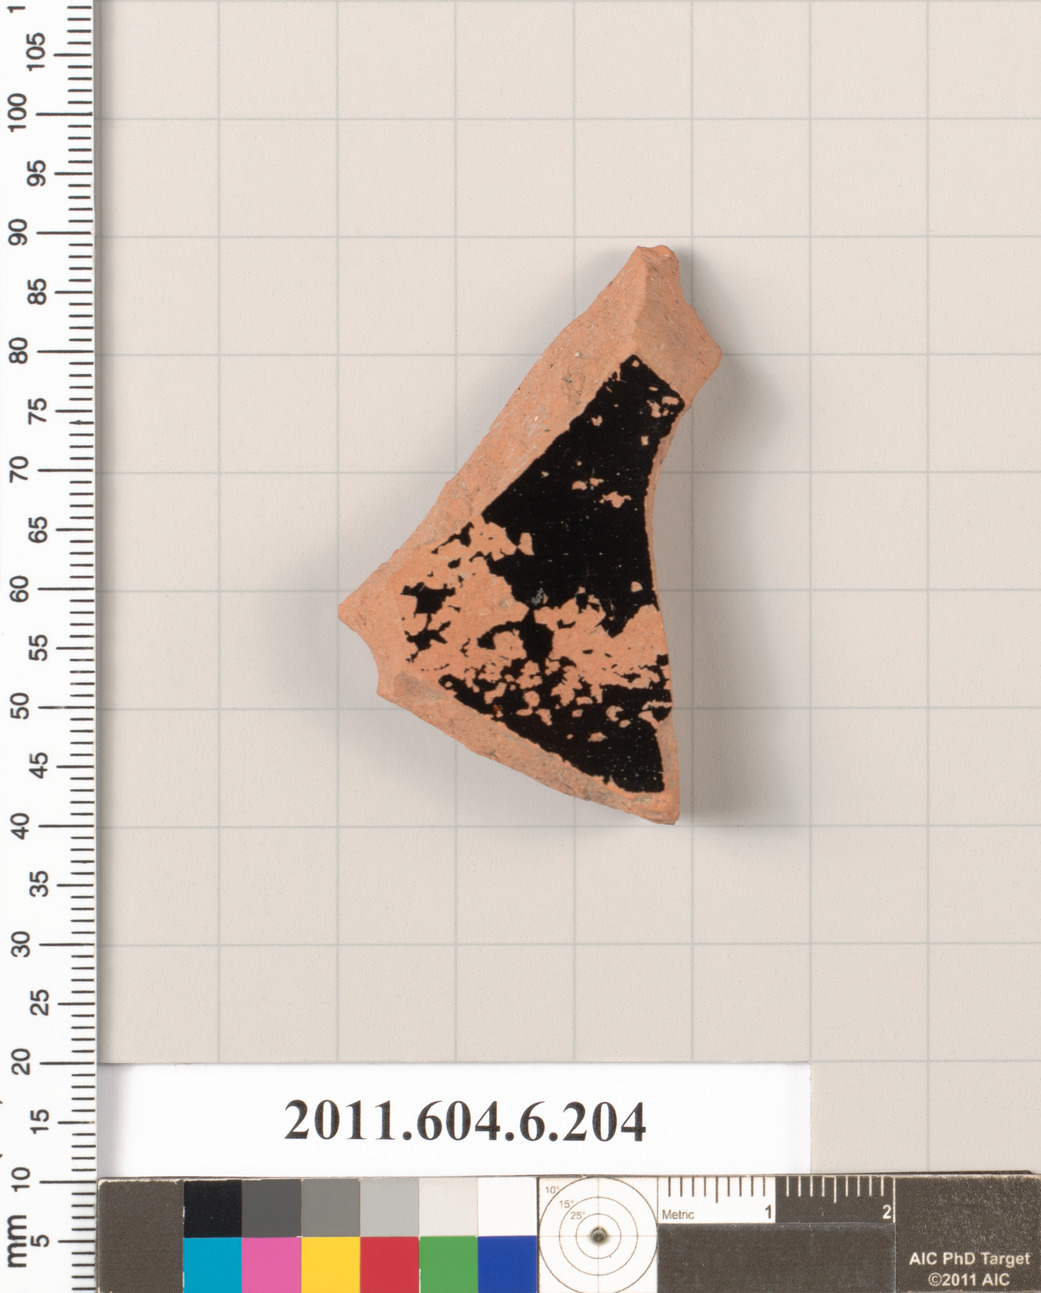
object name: lid fragment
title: Terracotta fragment of a lid?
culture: greek, attic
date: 600-401 BCE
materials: terracotta